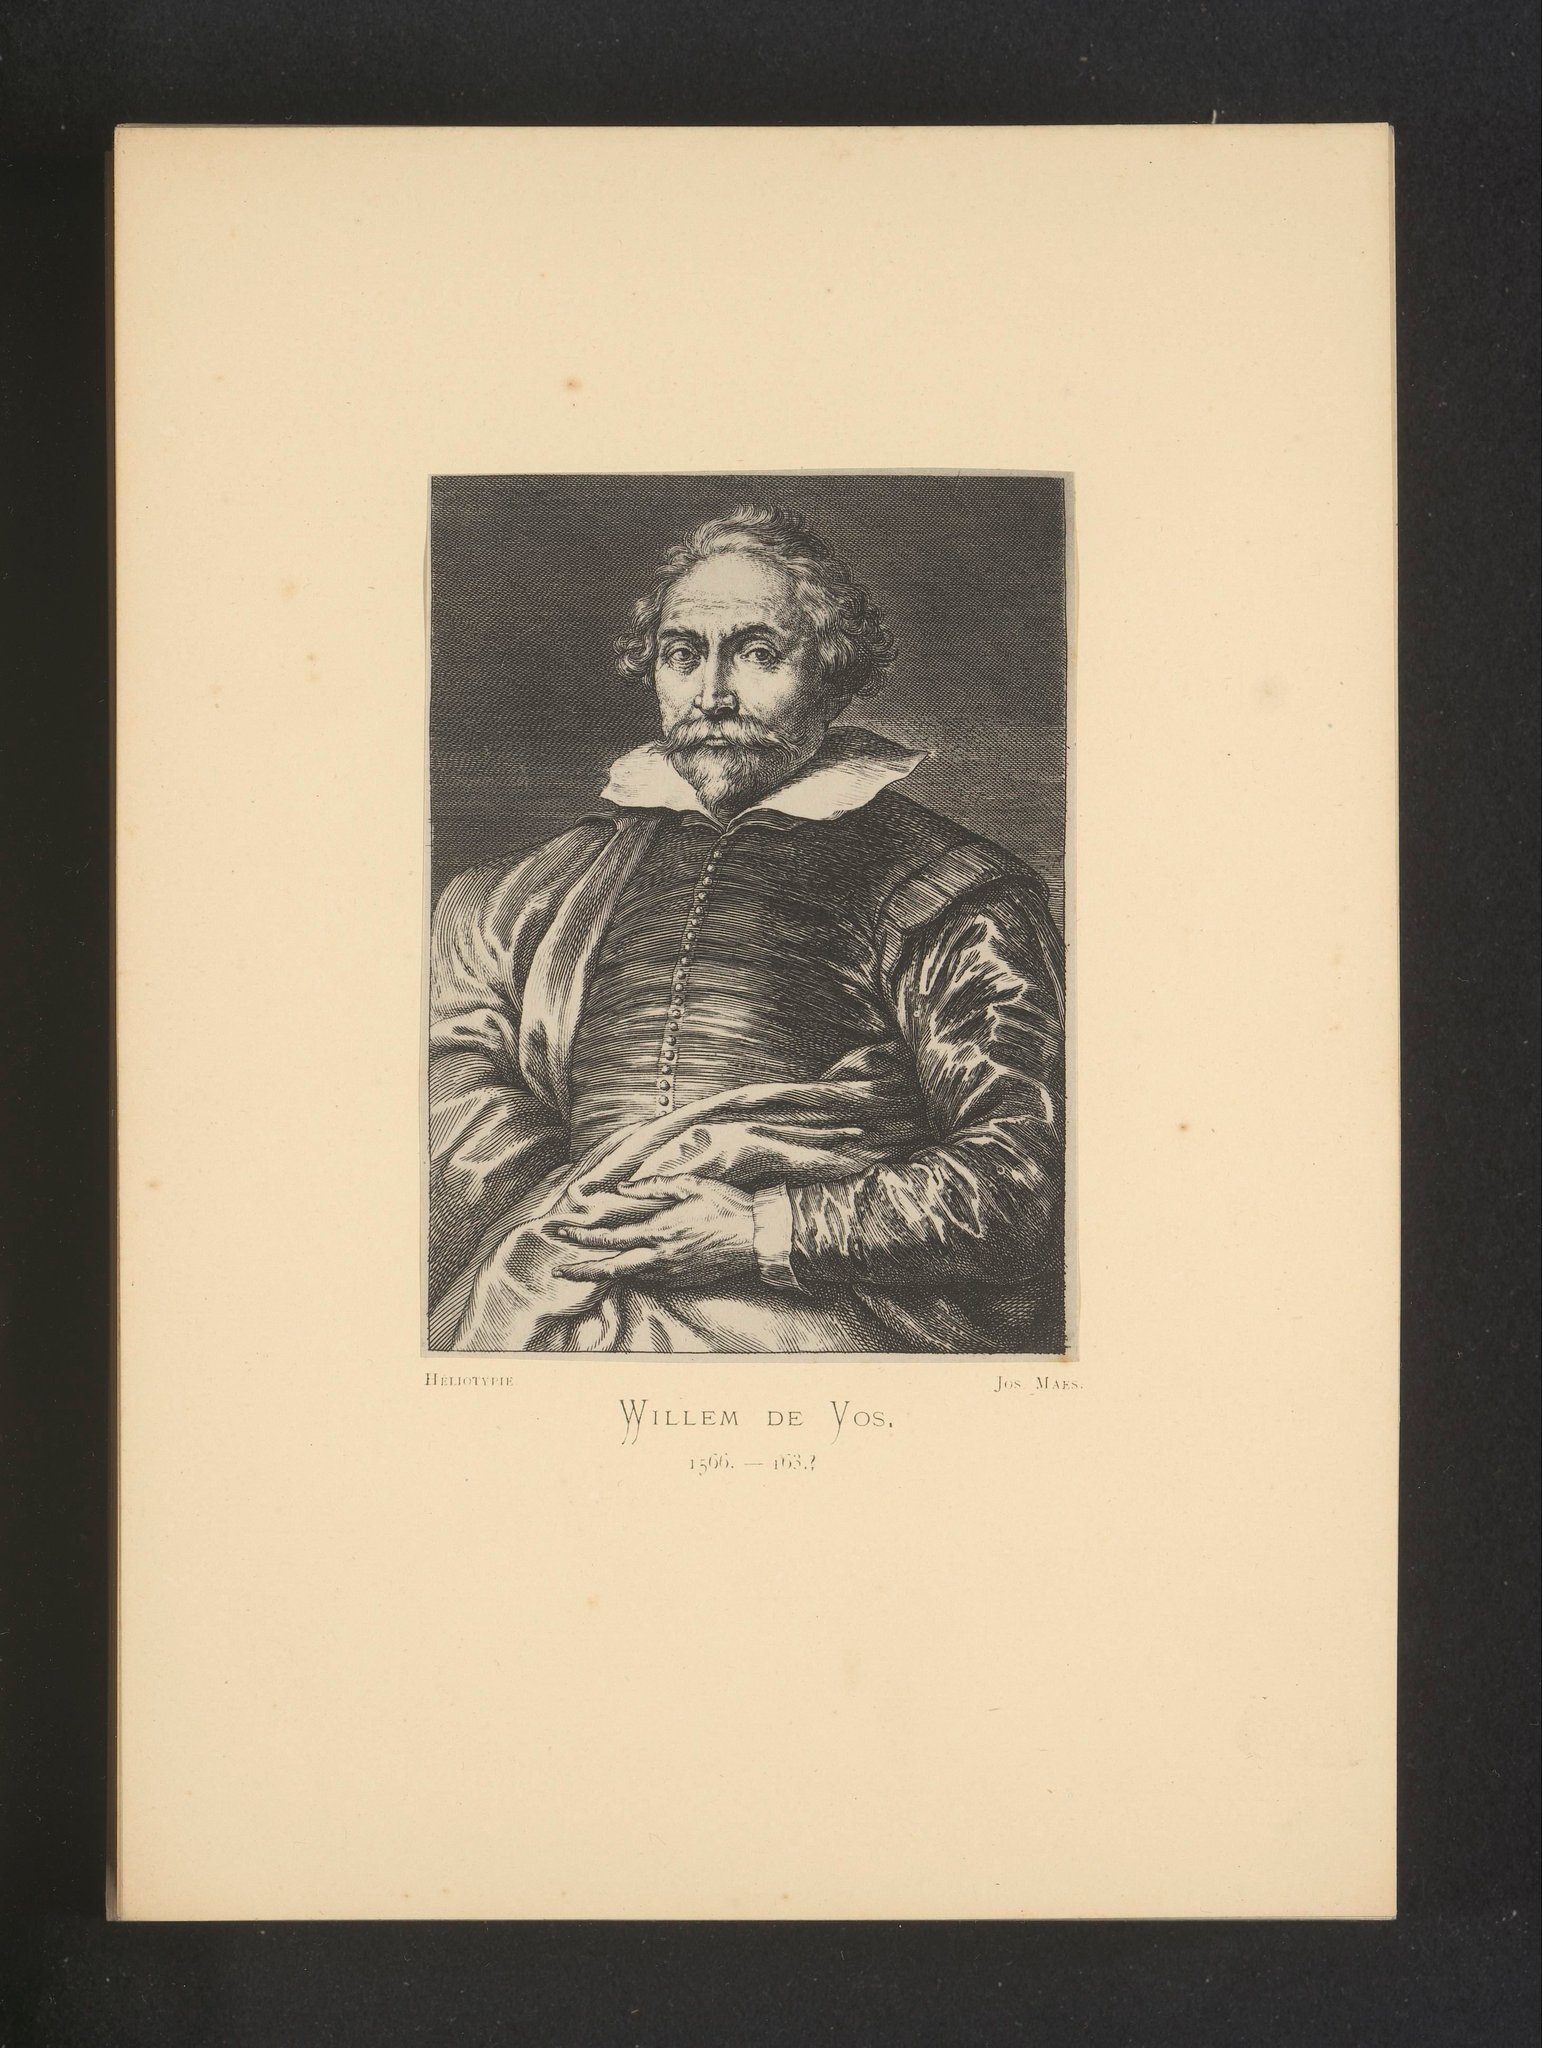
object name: reproduction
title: Willem de Vos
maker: joseph maes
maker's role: fotograaf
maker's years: 1838-1908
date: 1872-1877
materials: cardboard, paper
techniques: photograph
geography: antwerp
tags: historical persons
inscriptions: inscription: ‘1566. - 163.?’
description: Deze prent maakt deel uit van een omslag met 150 prenten en een katern met een lijst van afbeeldingen.